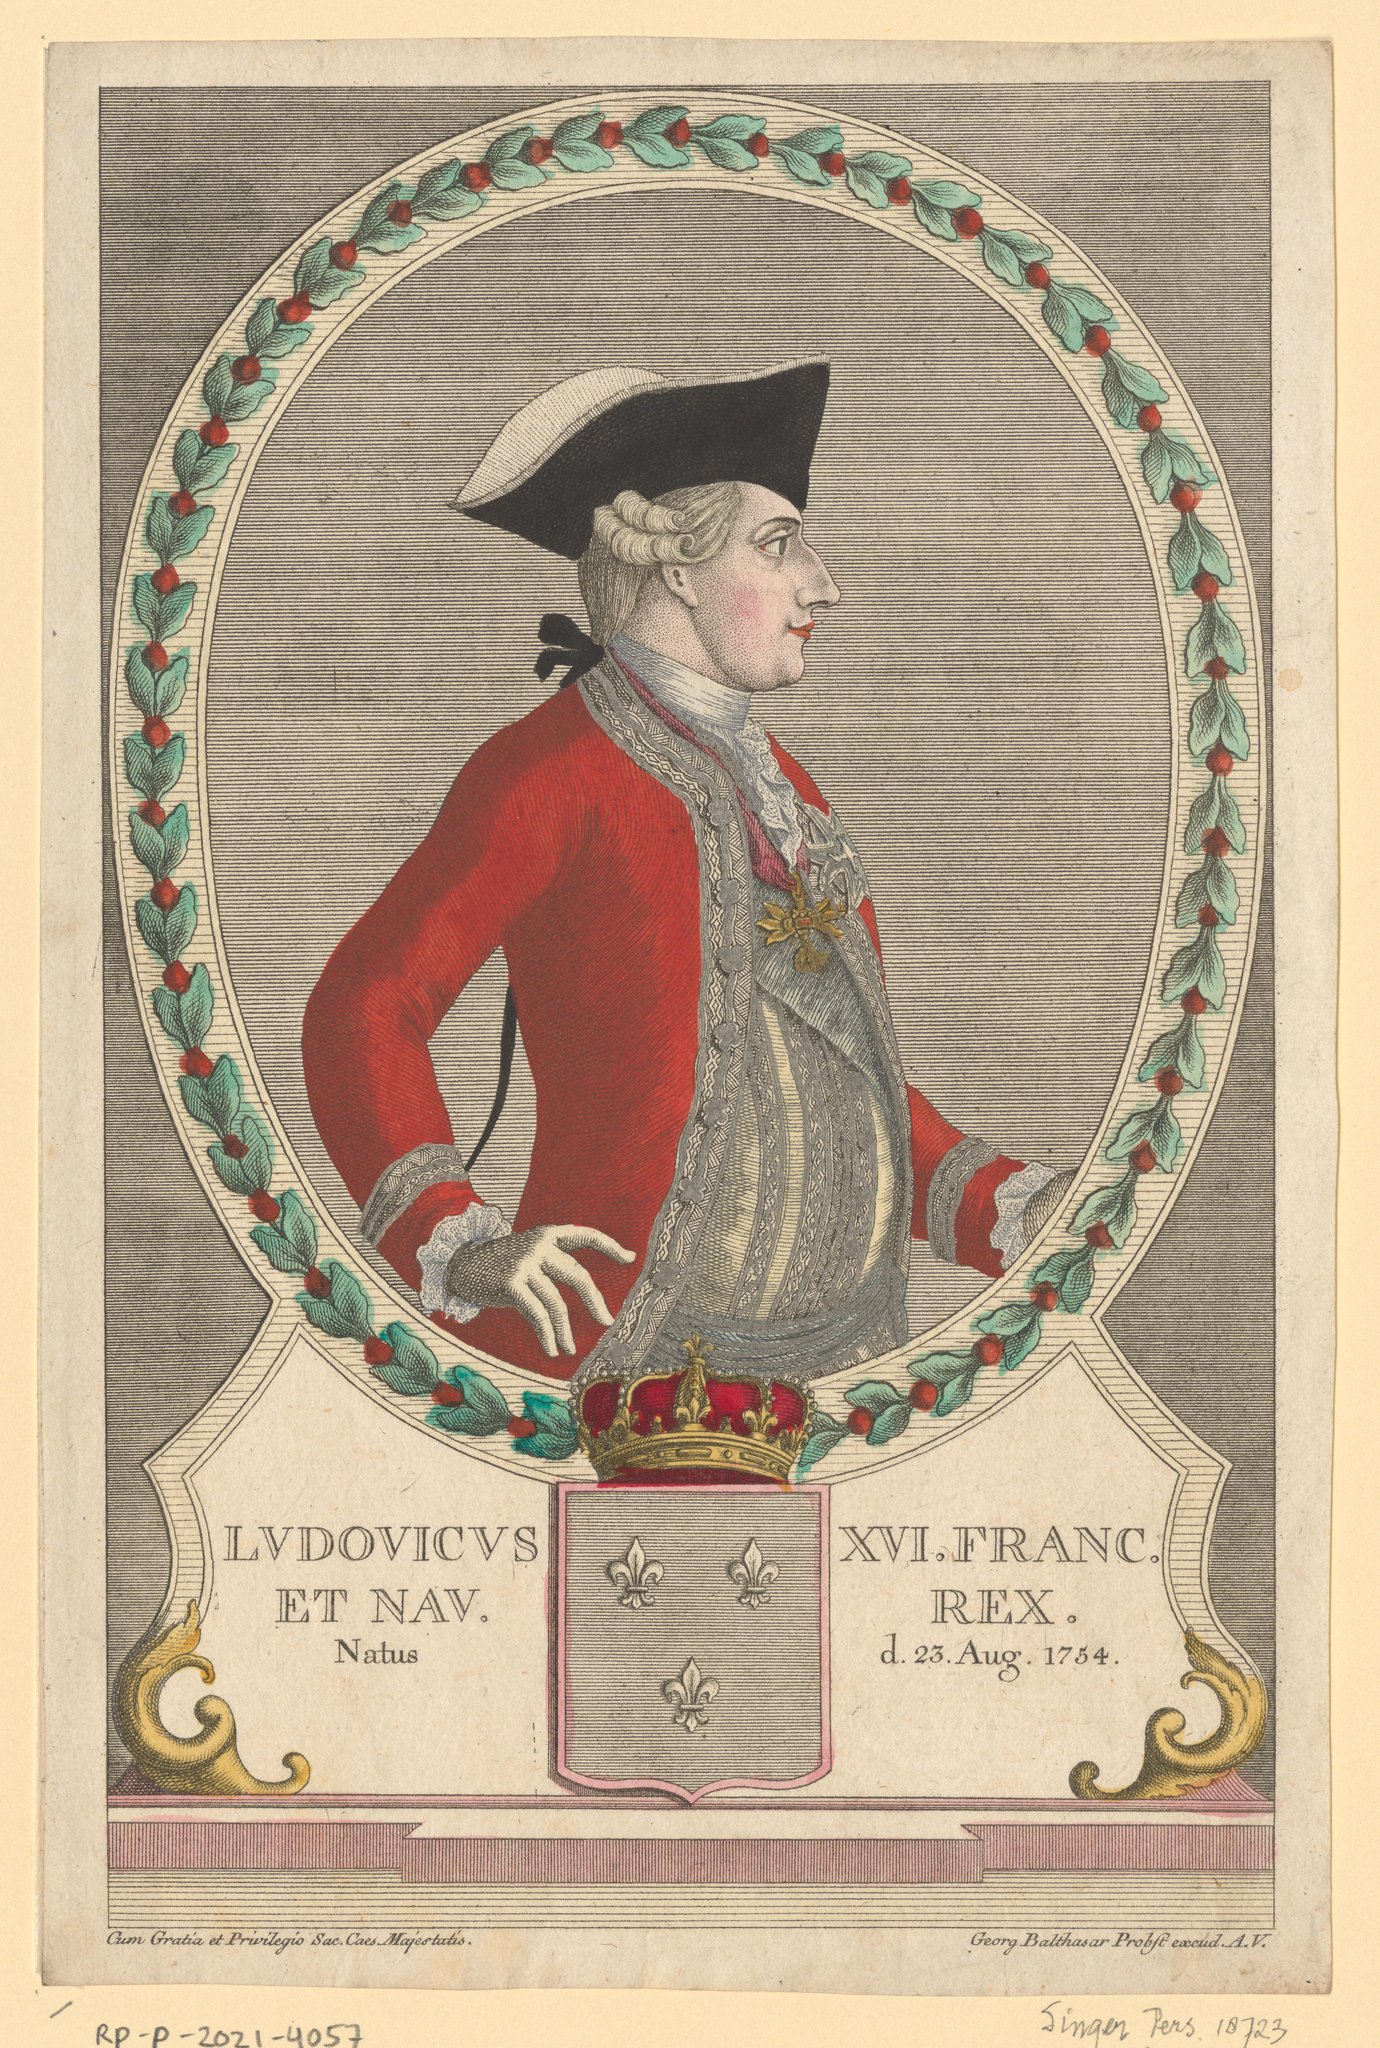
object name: print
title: Portret van Lodewijk XVI van Frankrijk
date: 1774-1793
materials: paper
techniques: etching, hand coloring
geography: germany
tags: lodewijk xvi (koning van frankrijk), coat of arms (symbol of sovereignty), crown (symbol of sovereignty), ornament ~ medallion, historical persons, wig, king